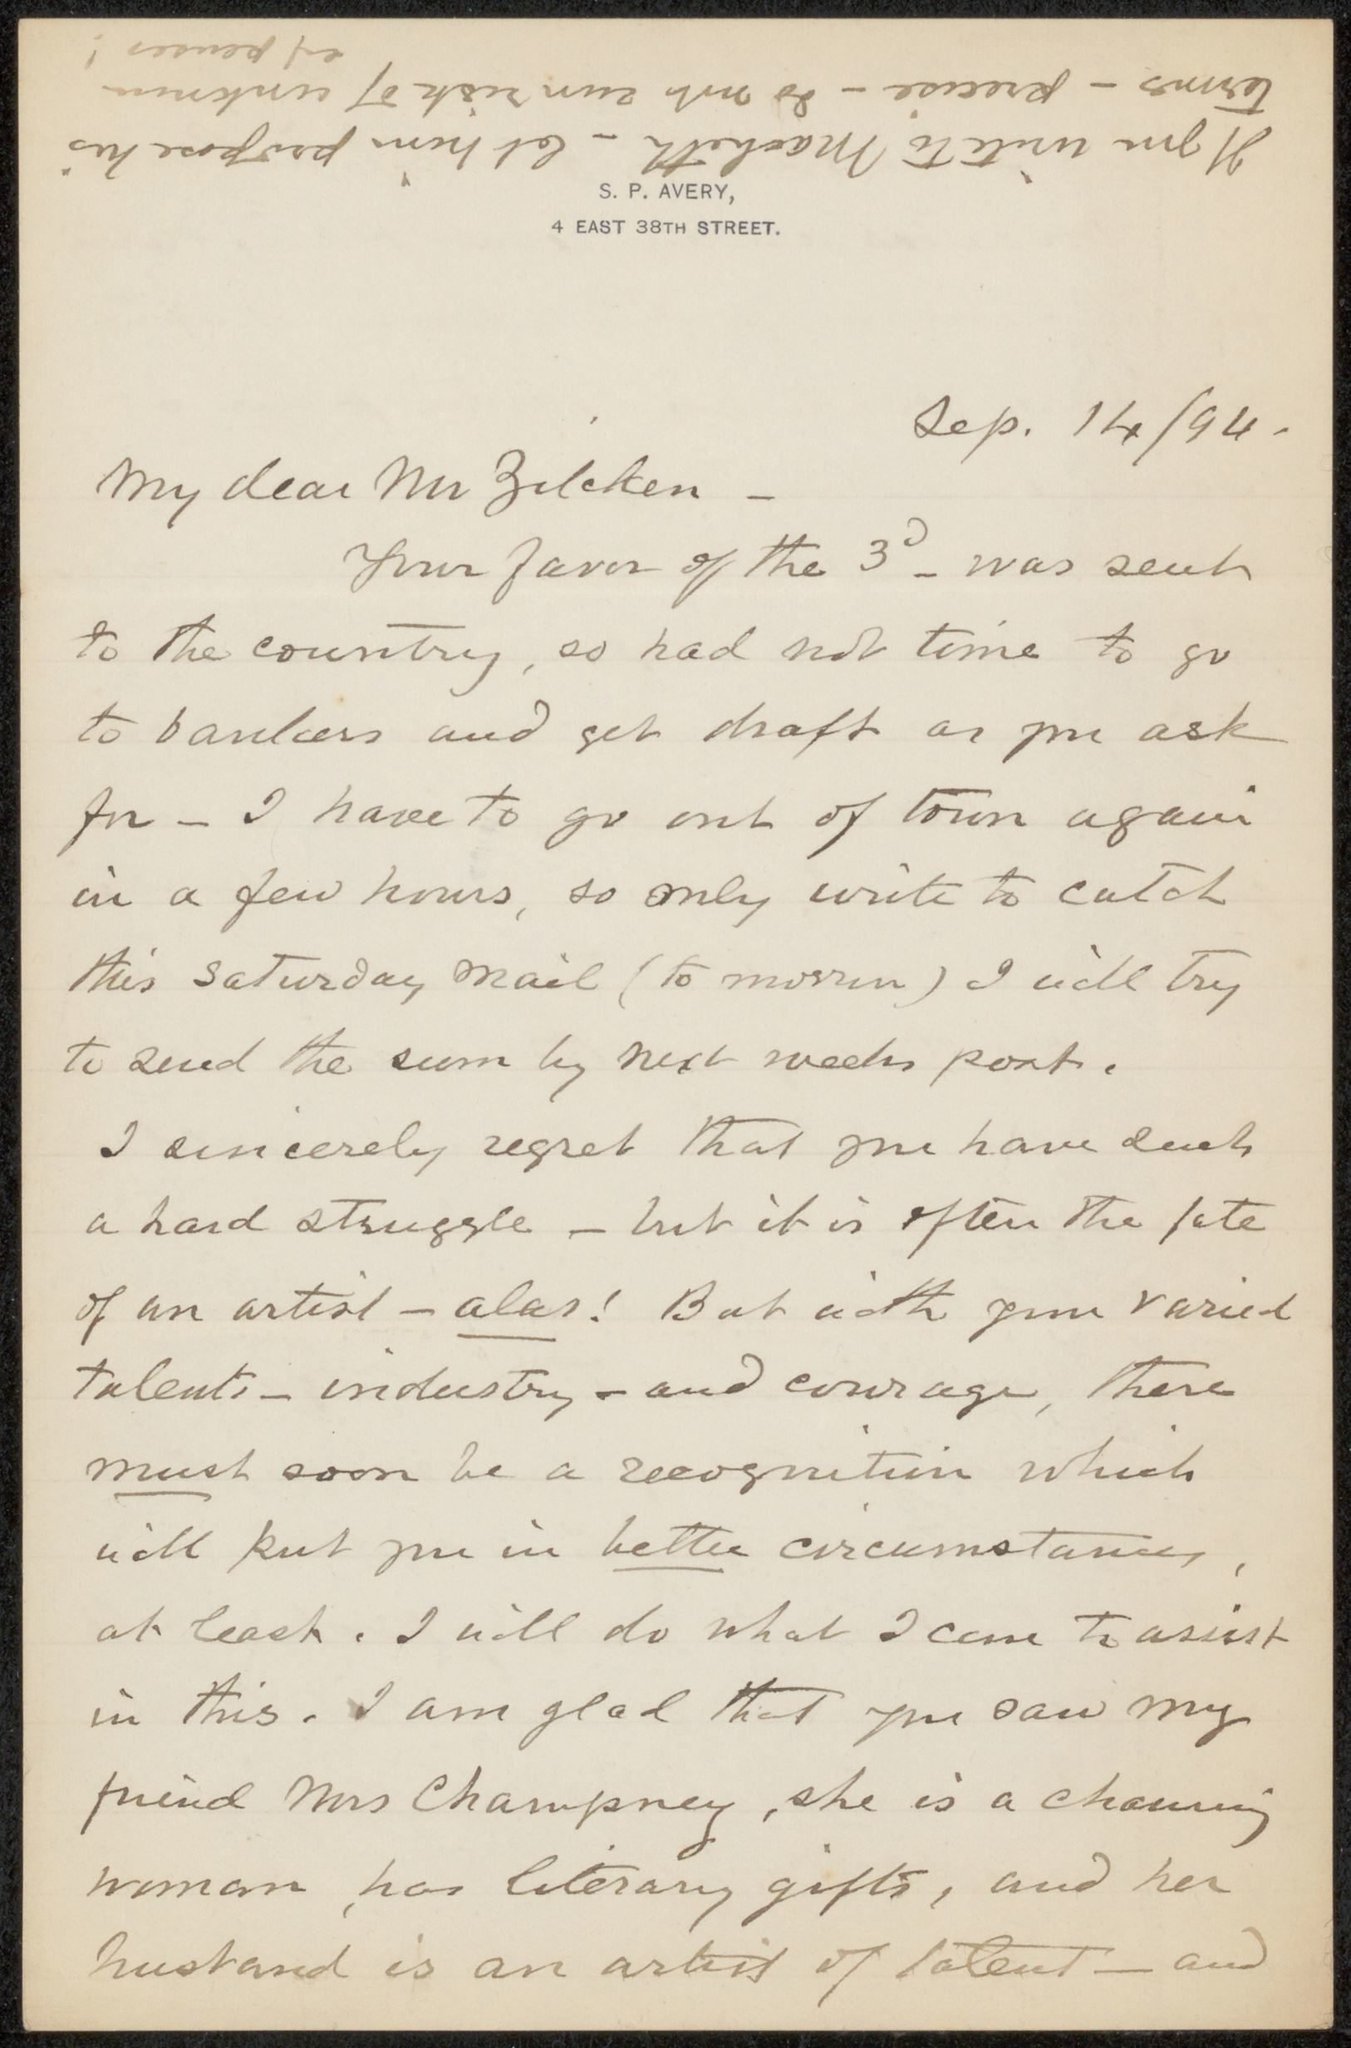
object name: letter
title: Brief aan Philip Zilcken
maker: samuel putnam avery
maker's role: verzamelaar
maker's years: 1822-1904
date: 1894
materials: ink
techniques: pen, printing, writing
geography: new york city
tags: arnhem, painter, print maker, anton mauve, william macbeth, elizabeth williams champney, the hague, philip zilcken, art trade, art shop, the graphic arts, paris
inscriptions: collector's mark: ‘RPK’